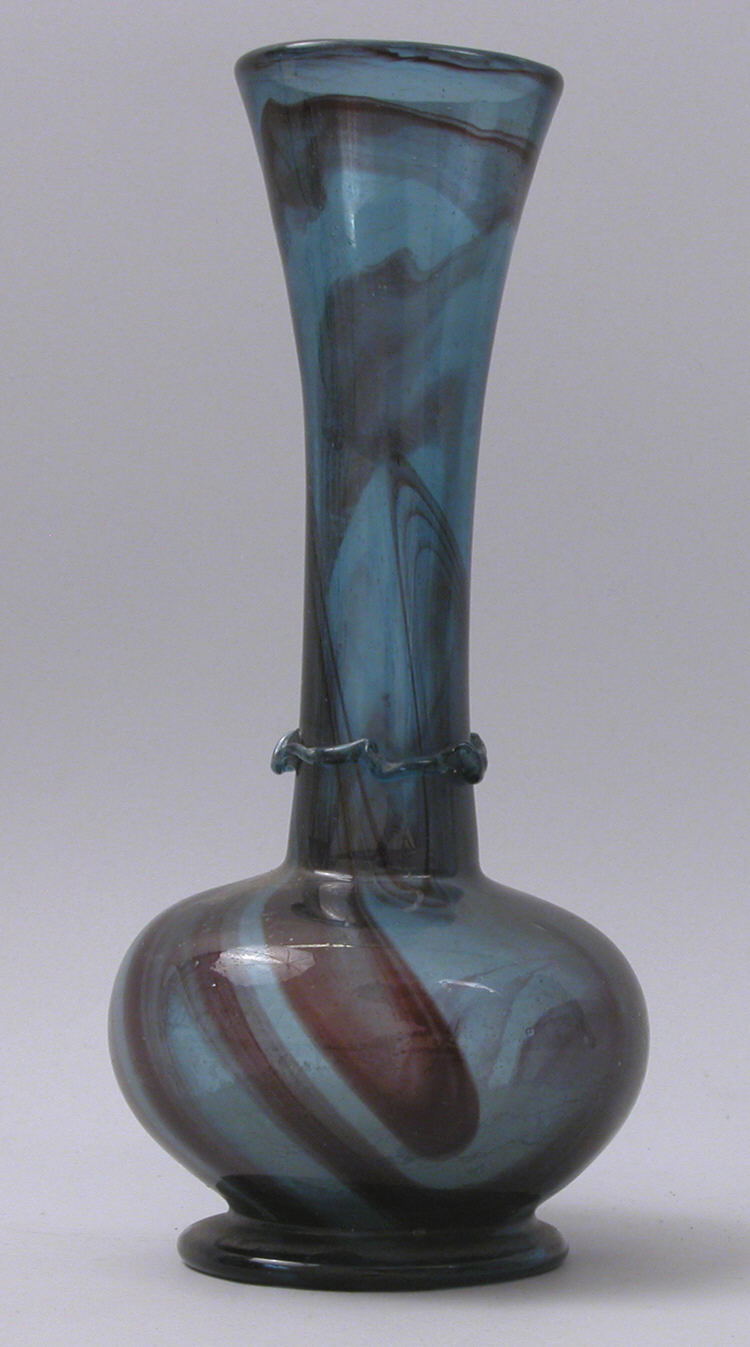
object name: bottle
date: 1701-1900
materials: glass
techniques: glassblowing, tooling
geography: iran